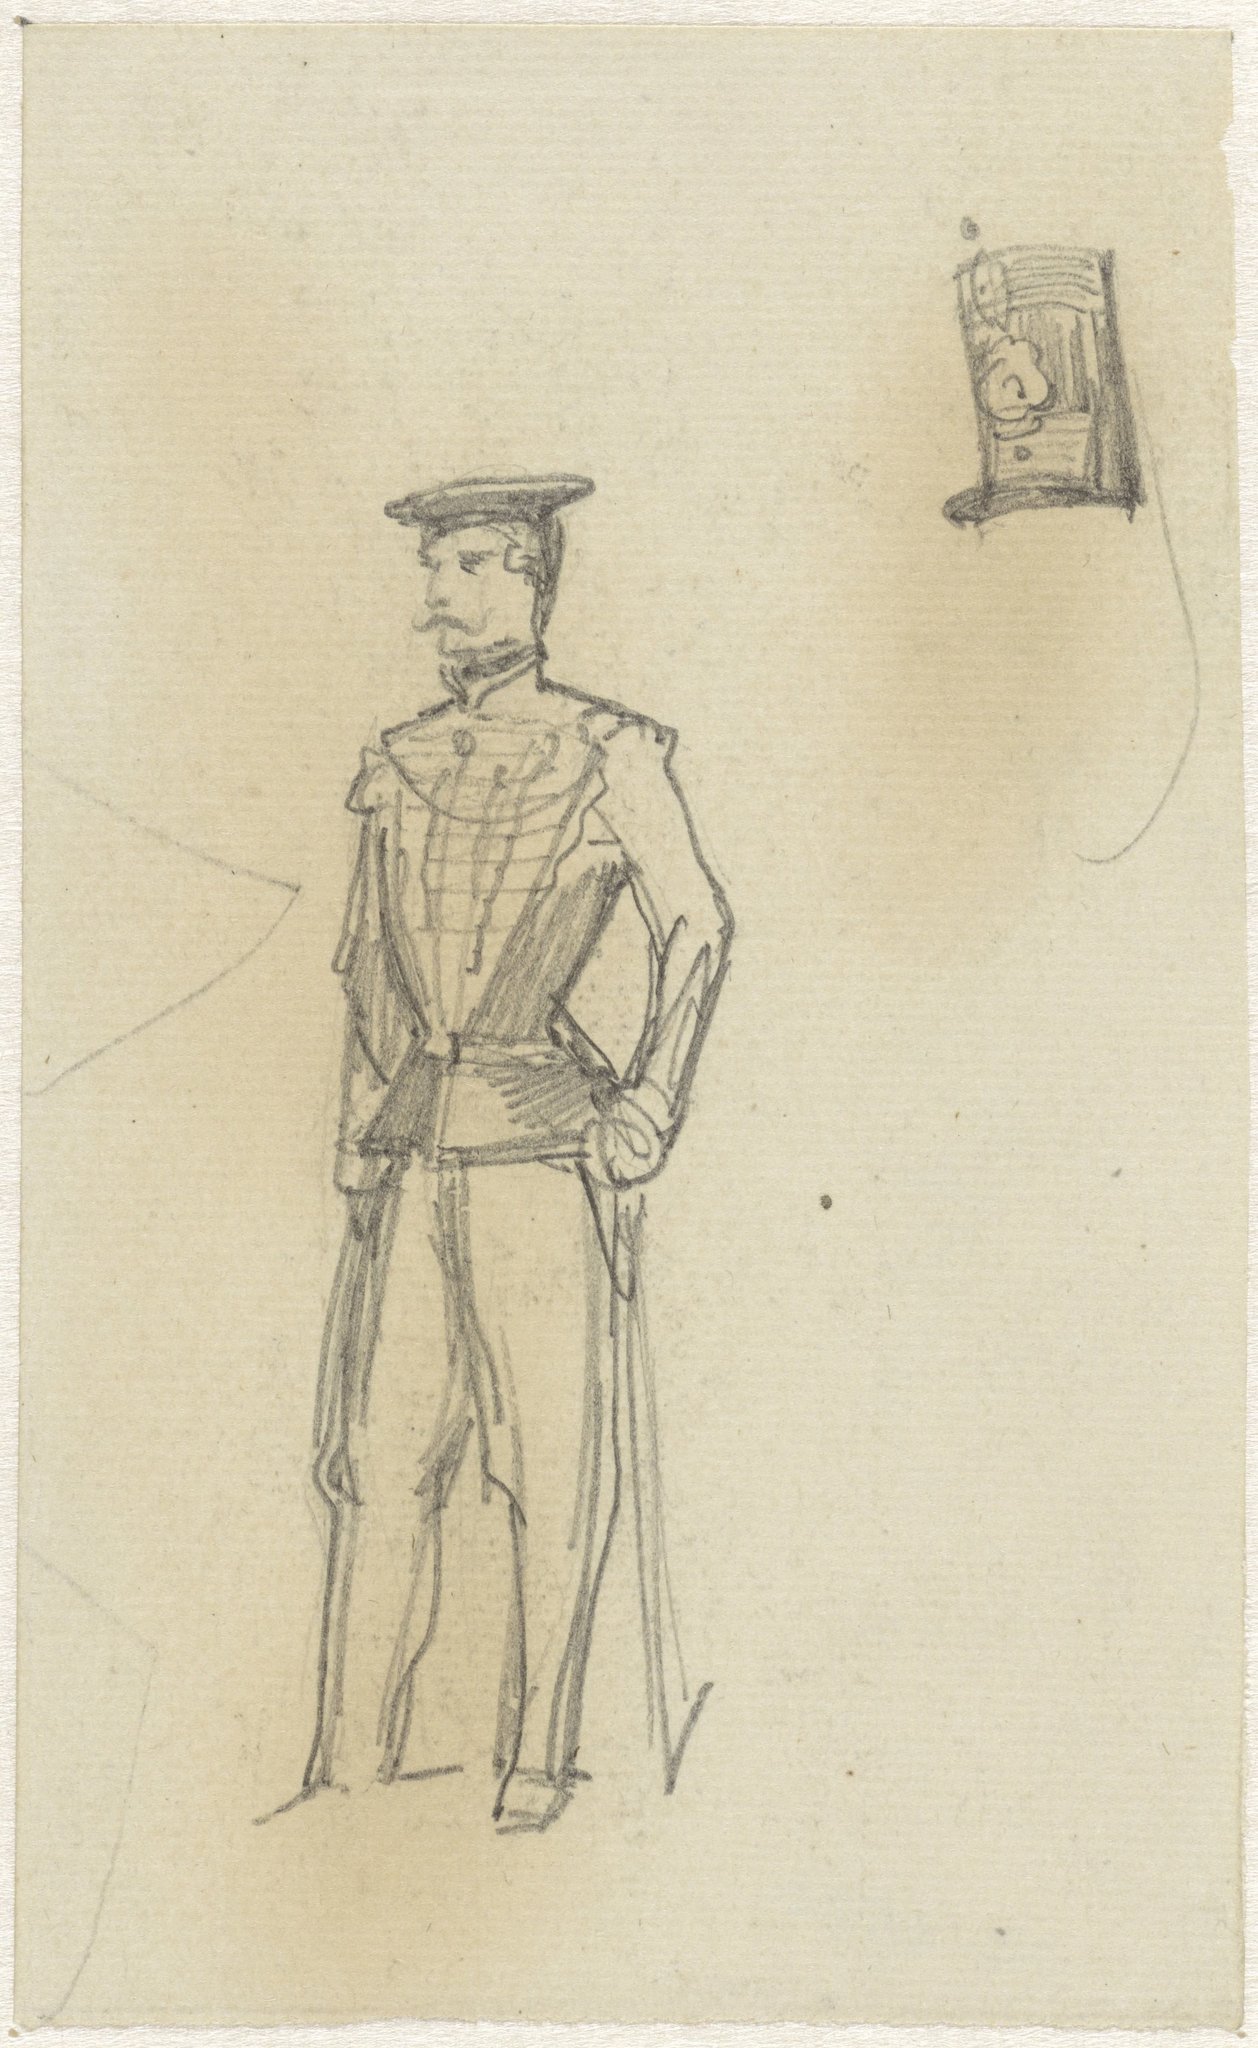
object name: drawing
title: Schets van man in kostuum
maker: charles rochussen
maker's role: draughtsman, painter, print maker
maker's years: 1814-1894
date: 1824-1894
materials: paper, pencil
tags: standing figure, male sex; man